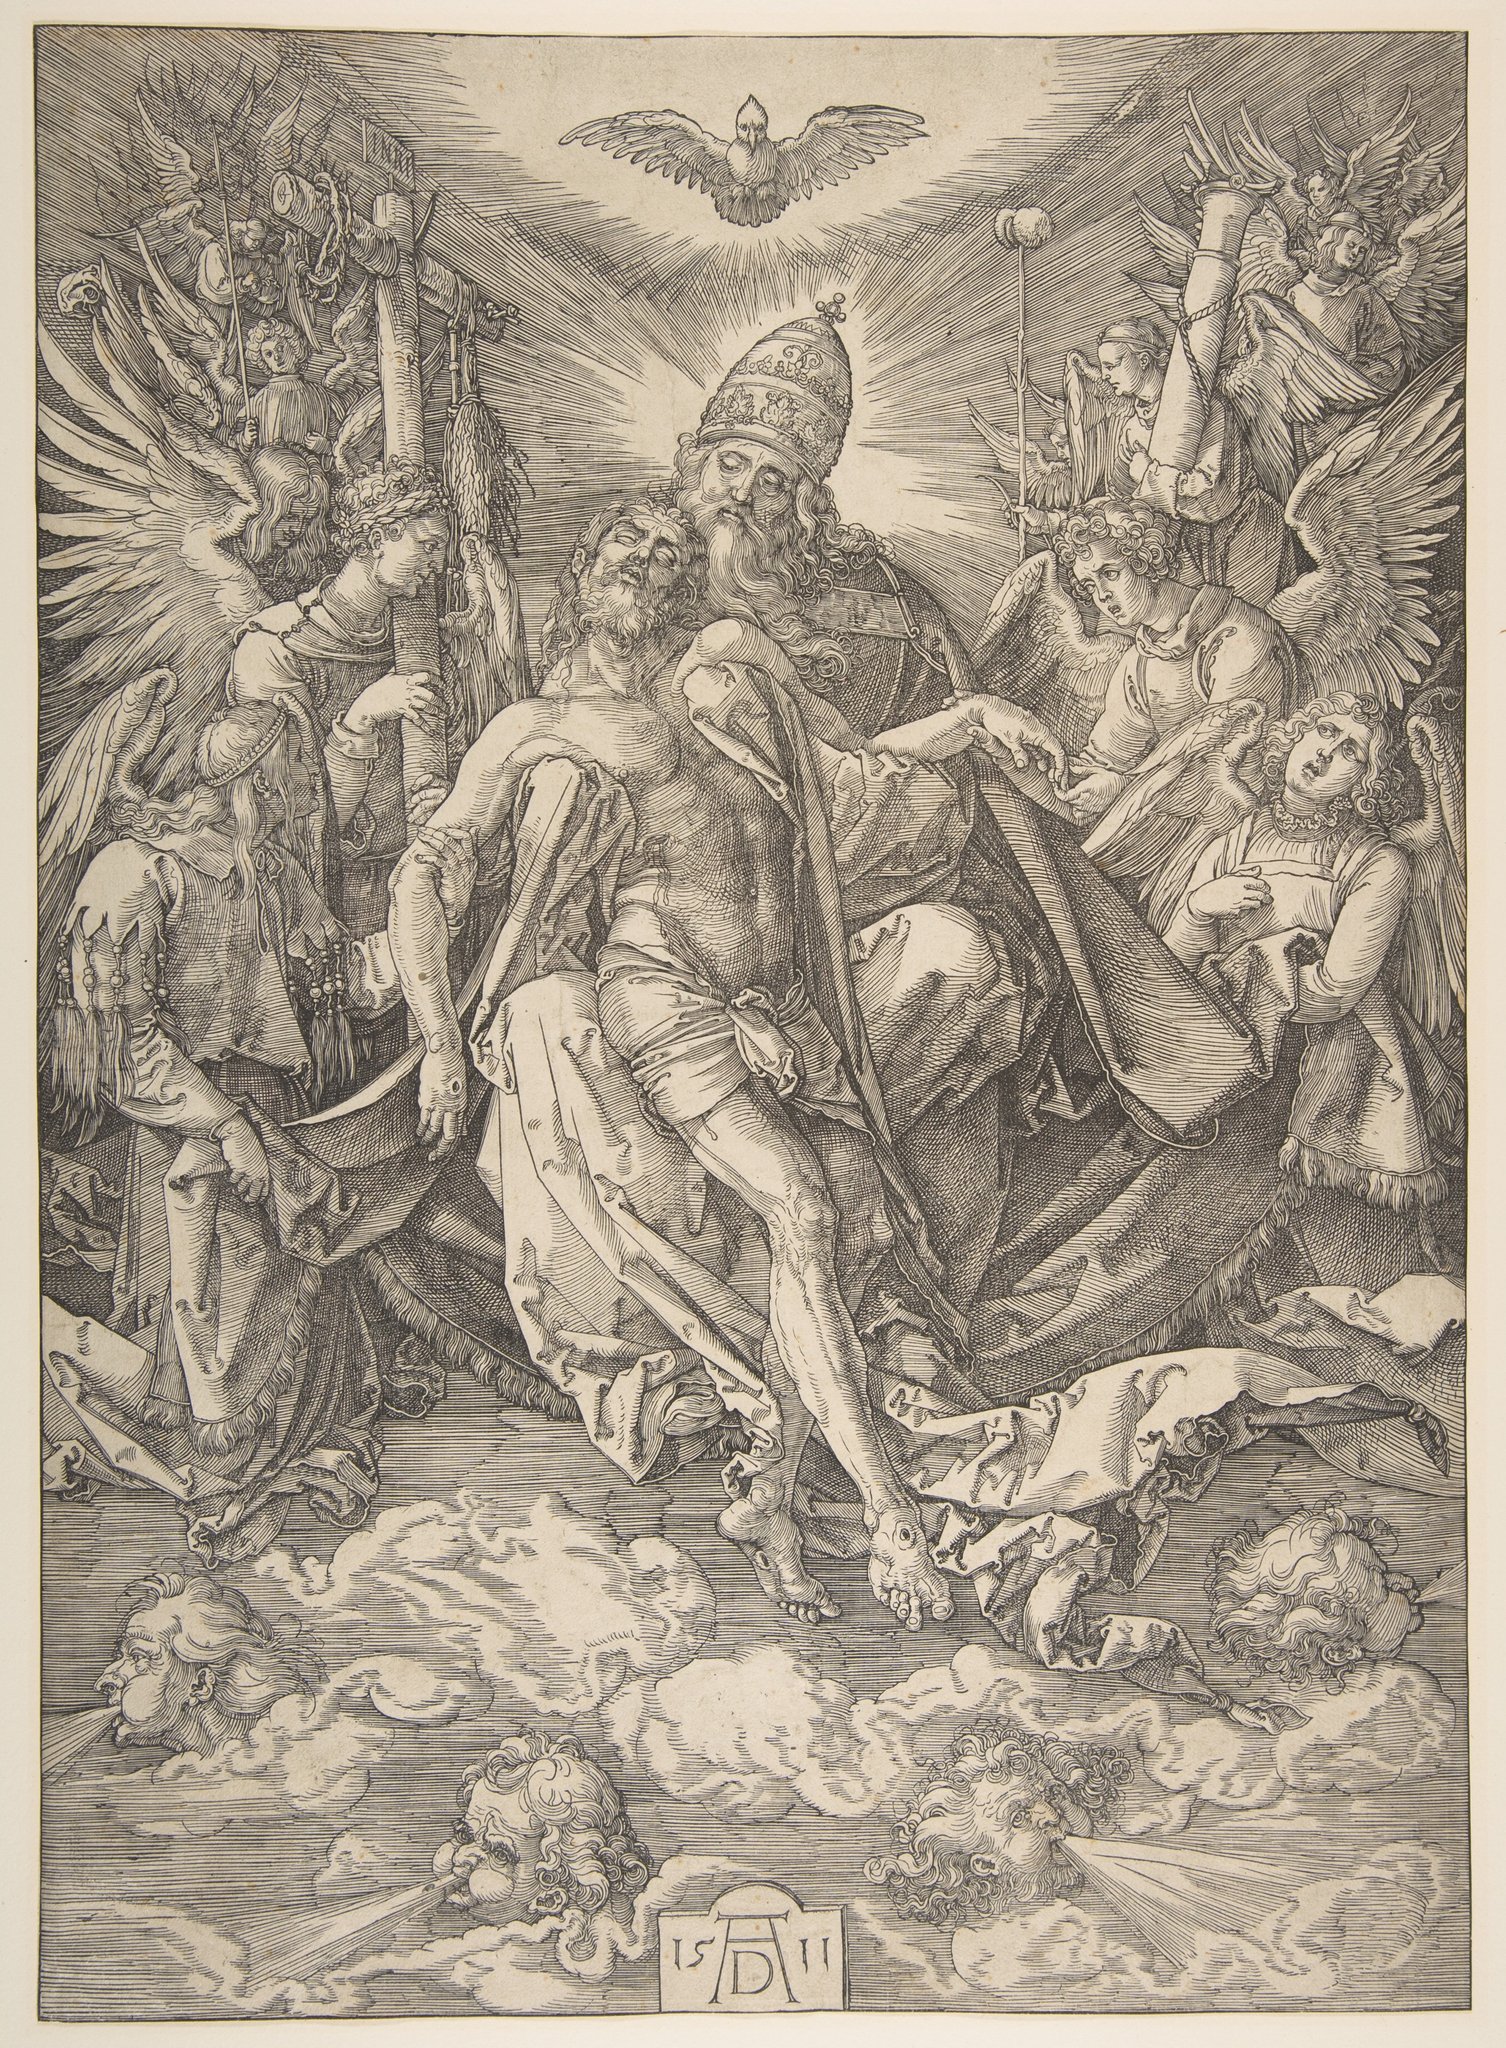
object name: print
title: The Holy Trinity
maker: albrecht dürer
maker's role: artist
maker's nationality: german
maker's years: 1471-1528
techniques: woodcut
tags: birds,angels,christ,cross